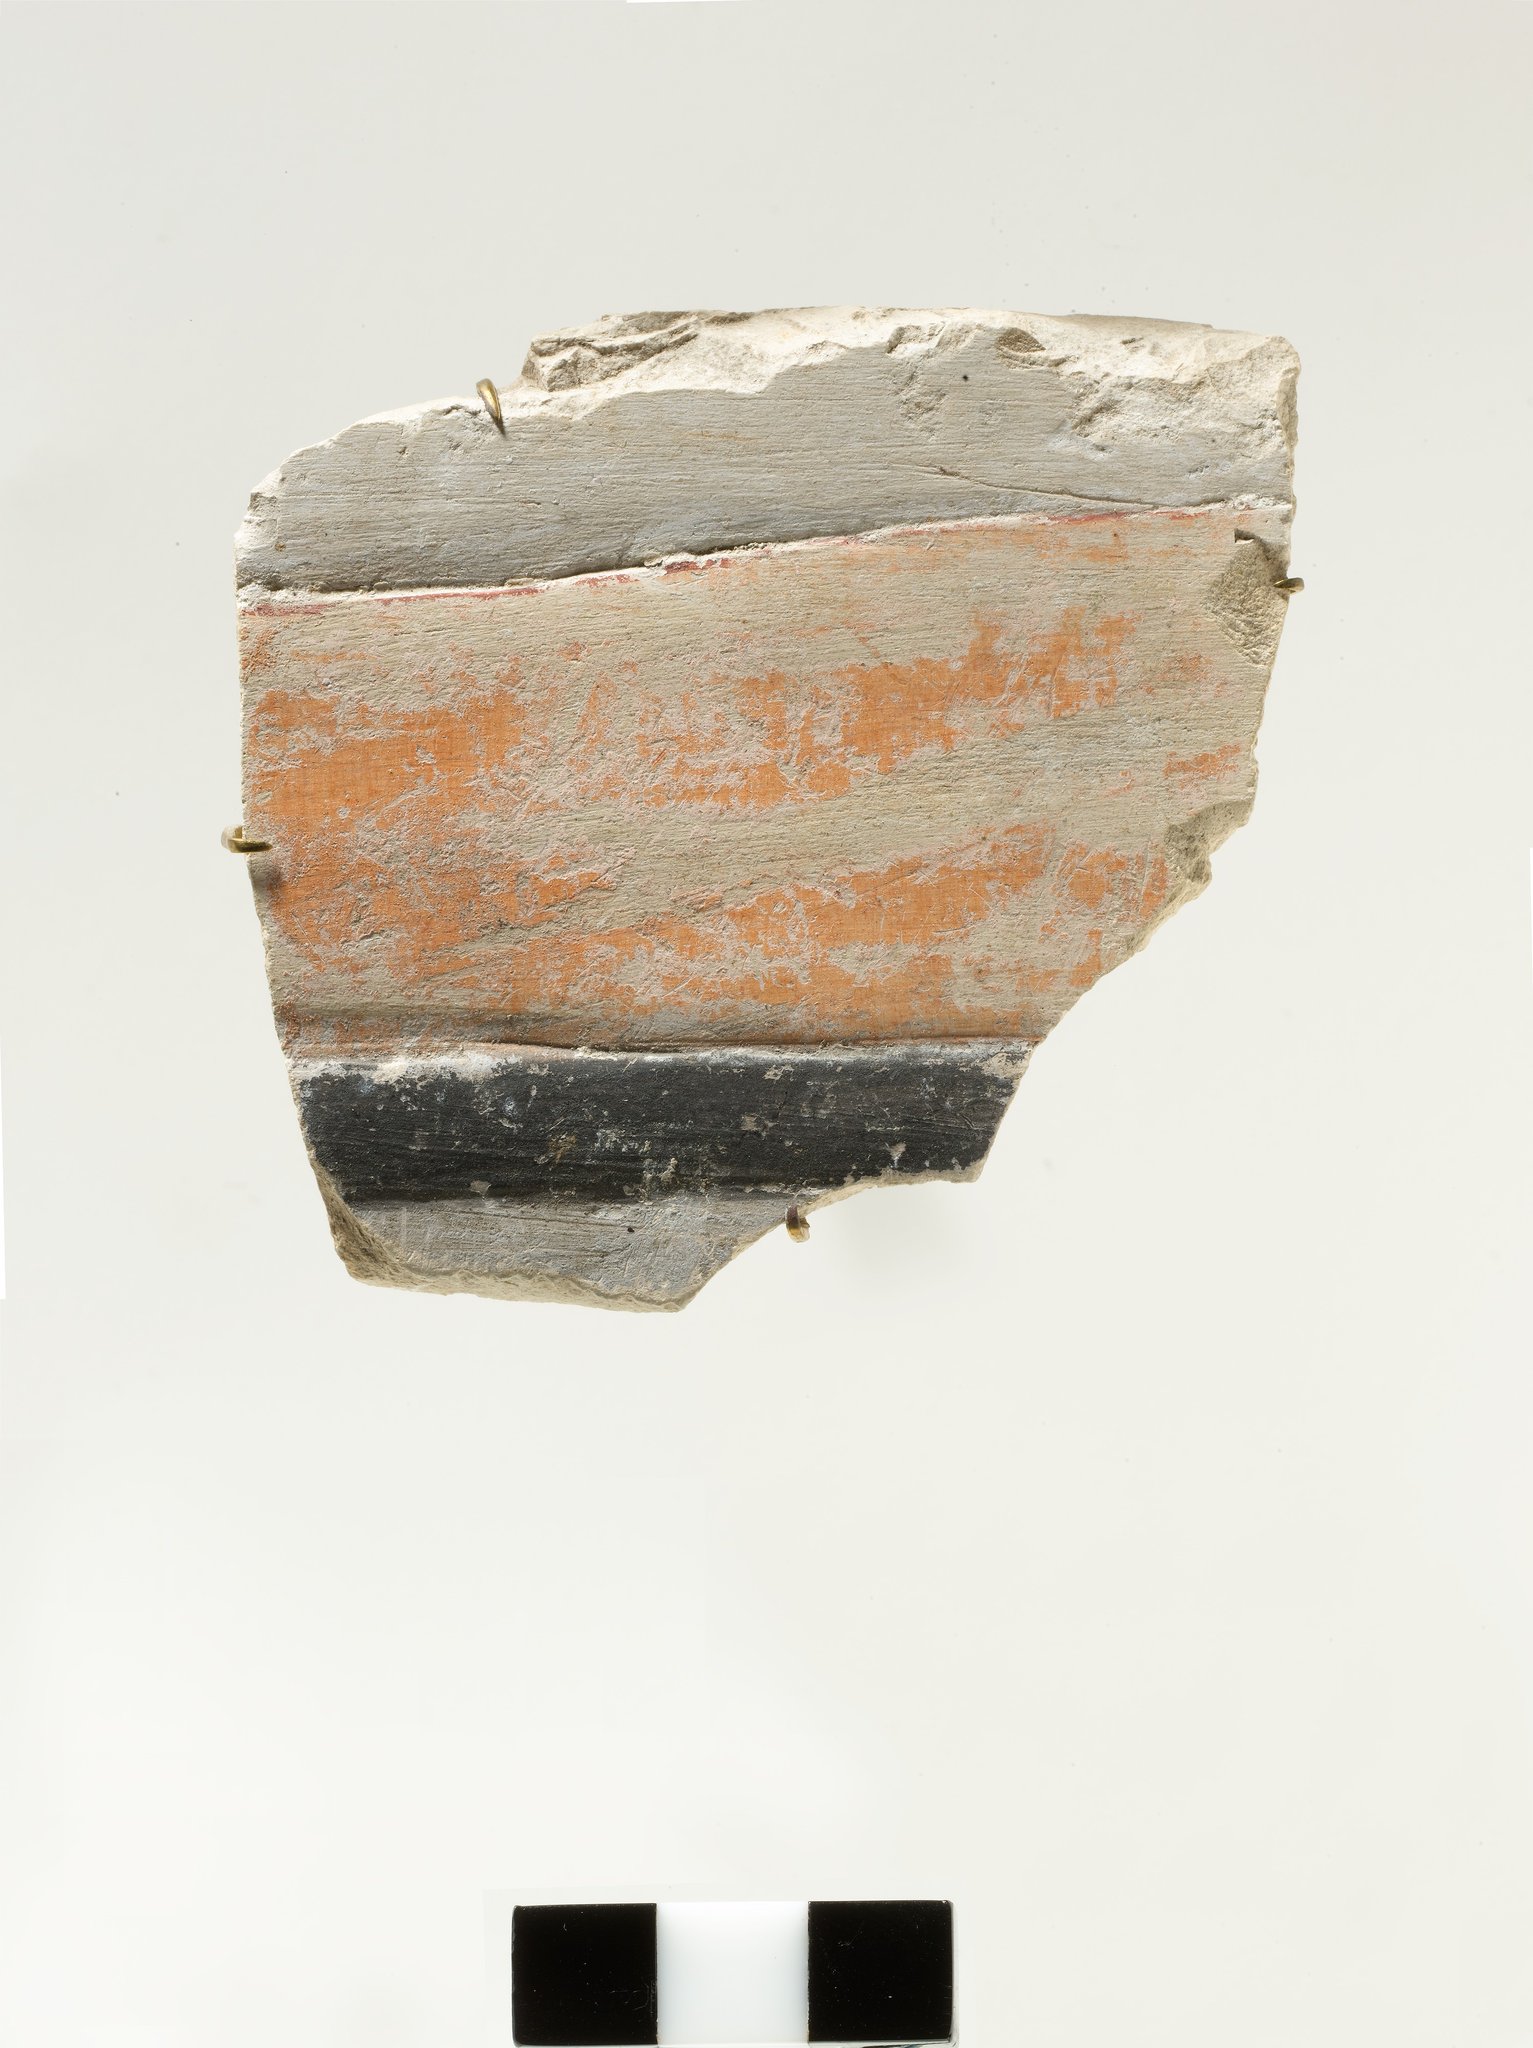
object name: relief fragment, tomb of meketre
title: Reliefs from the tomb of Meketre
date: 1981-1975 BCE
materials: limestone, paint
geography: egypt